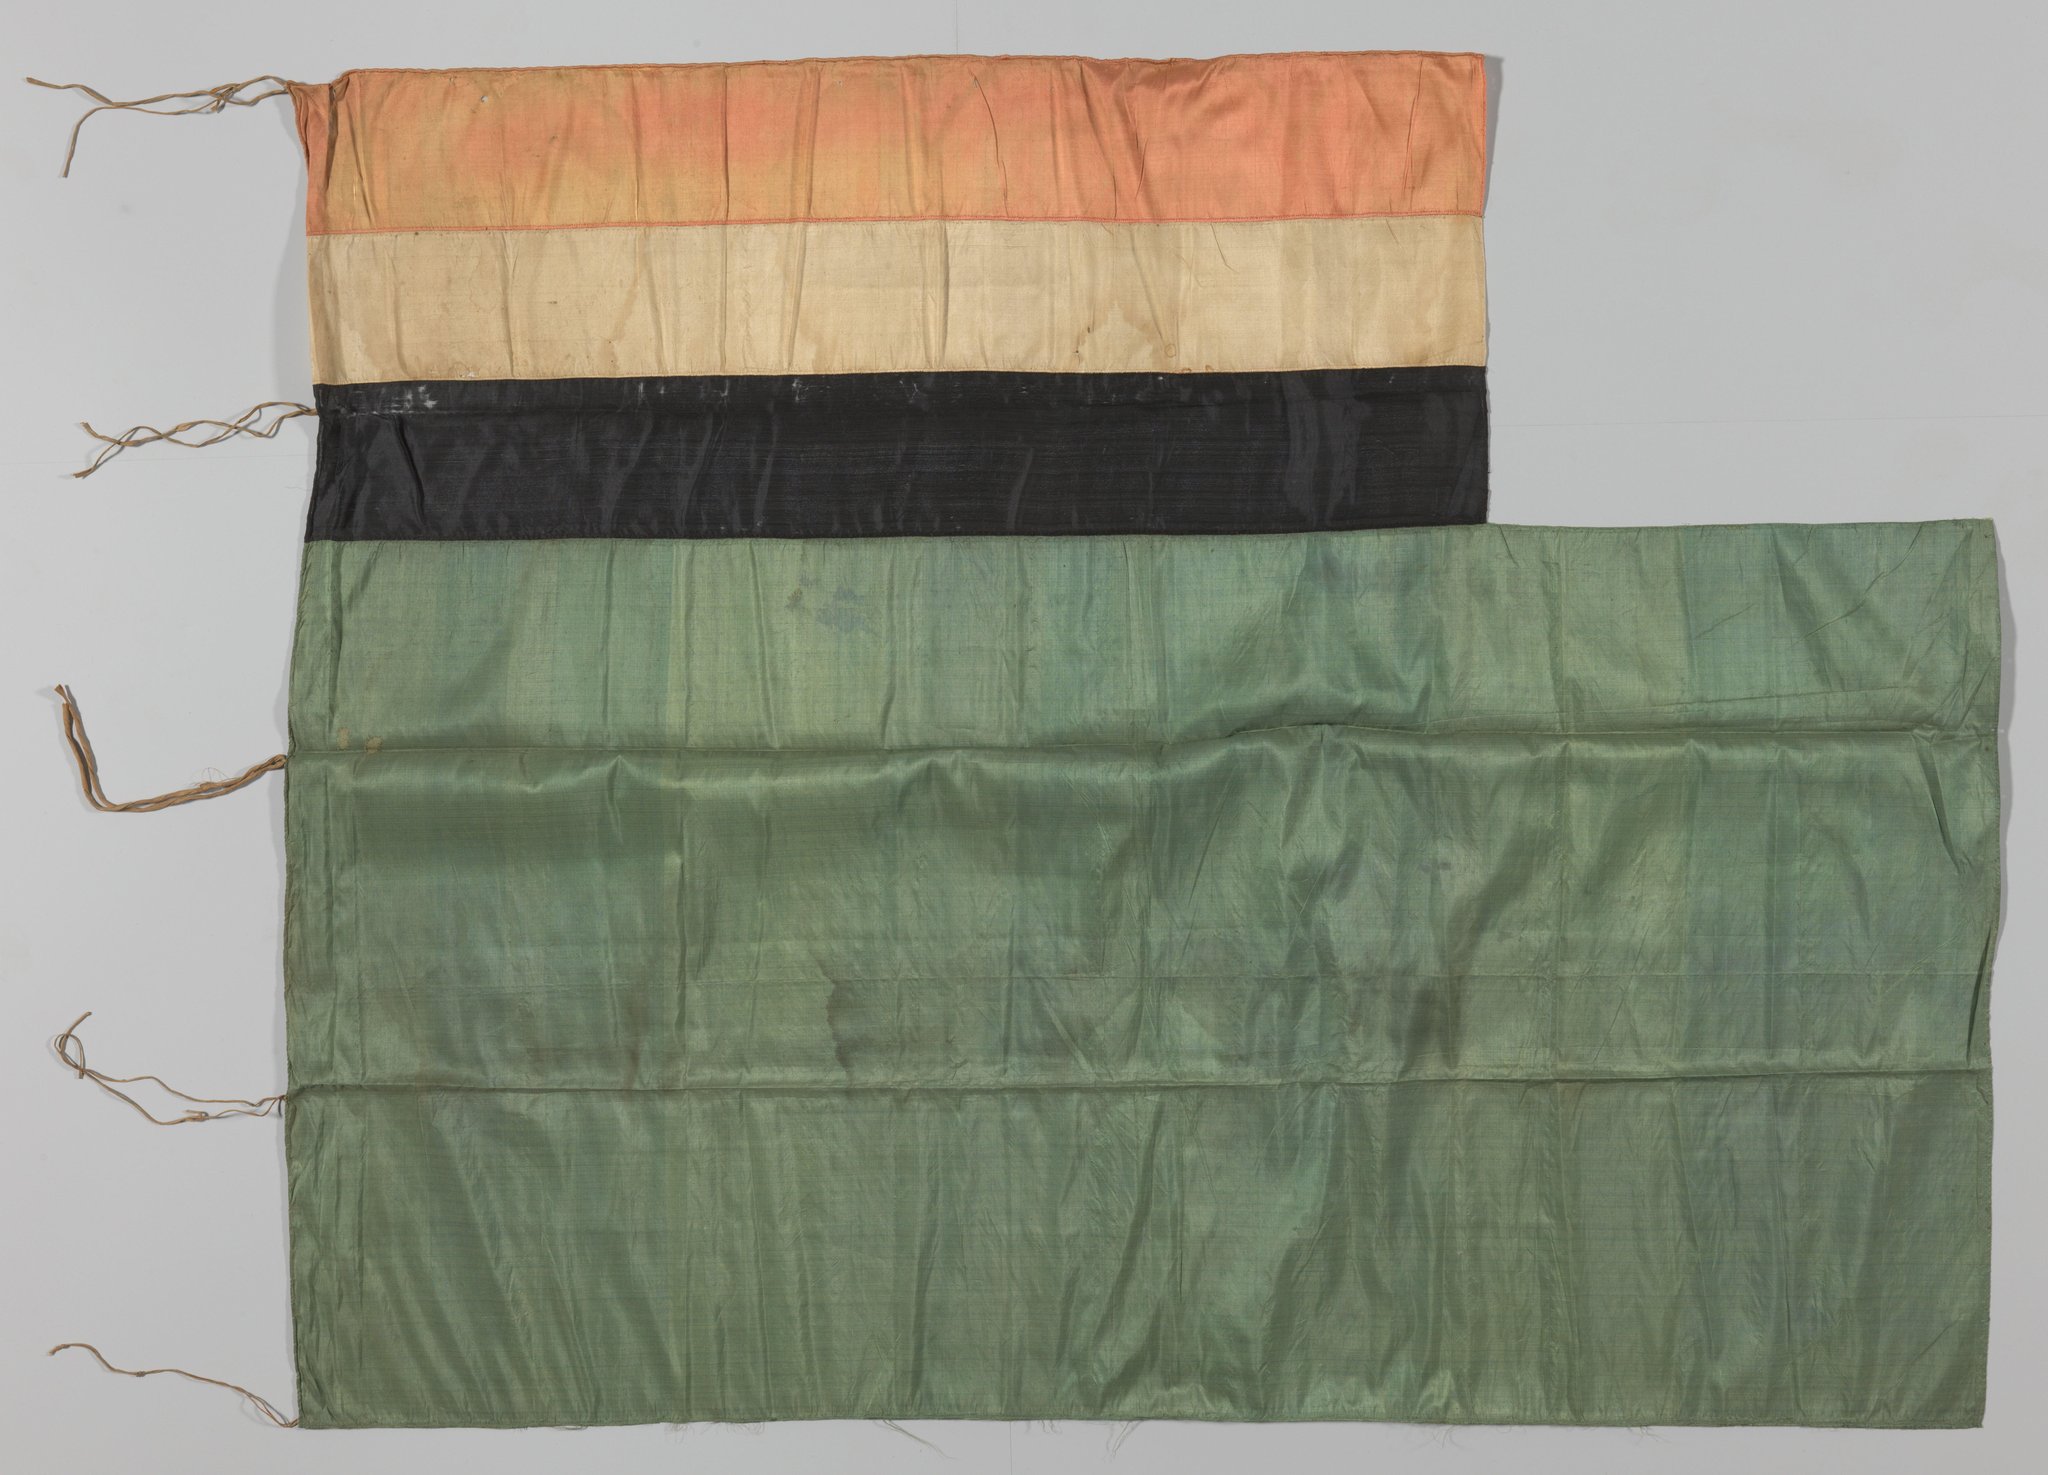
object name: banner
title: Amsterdams schuttersvaandel van het groene regiment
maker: Anonymous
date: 1750-1795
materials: silk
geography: netherlands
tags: amsterdam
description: Amsterdams schuttersvaandel van het groene regiment. Groen zijden vaandel met aan bovenzijde een rood, wit, zwarte baan. Deze baan loopt tot aan de uitsparing waar het wapen is geweest. De rode kleur is verkleurd tot oranje en de witte tot geel. Voorkant en paradekant van het vaandel zijn identiek. Aan de broekzijde is op vijf plaatsen een ongebleekt katoenen lint genaaid.